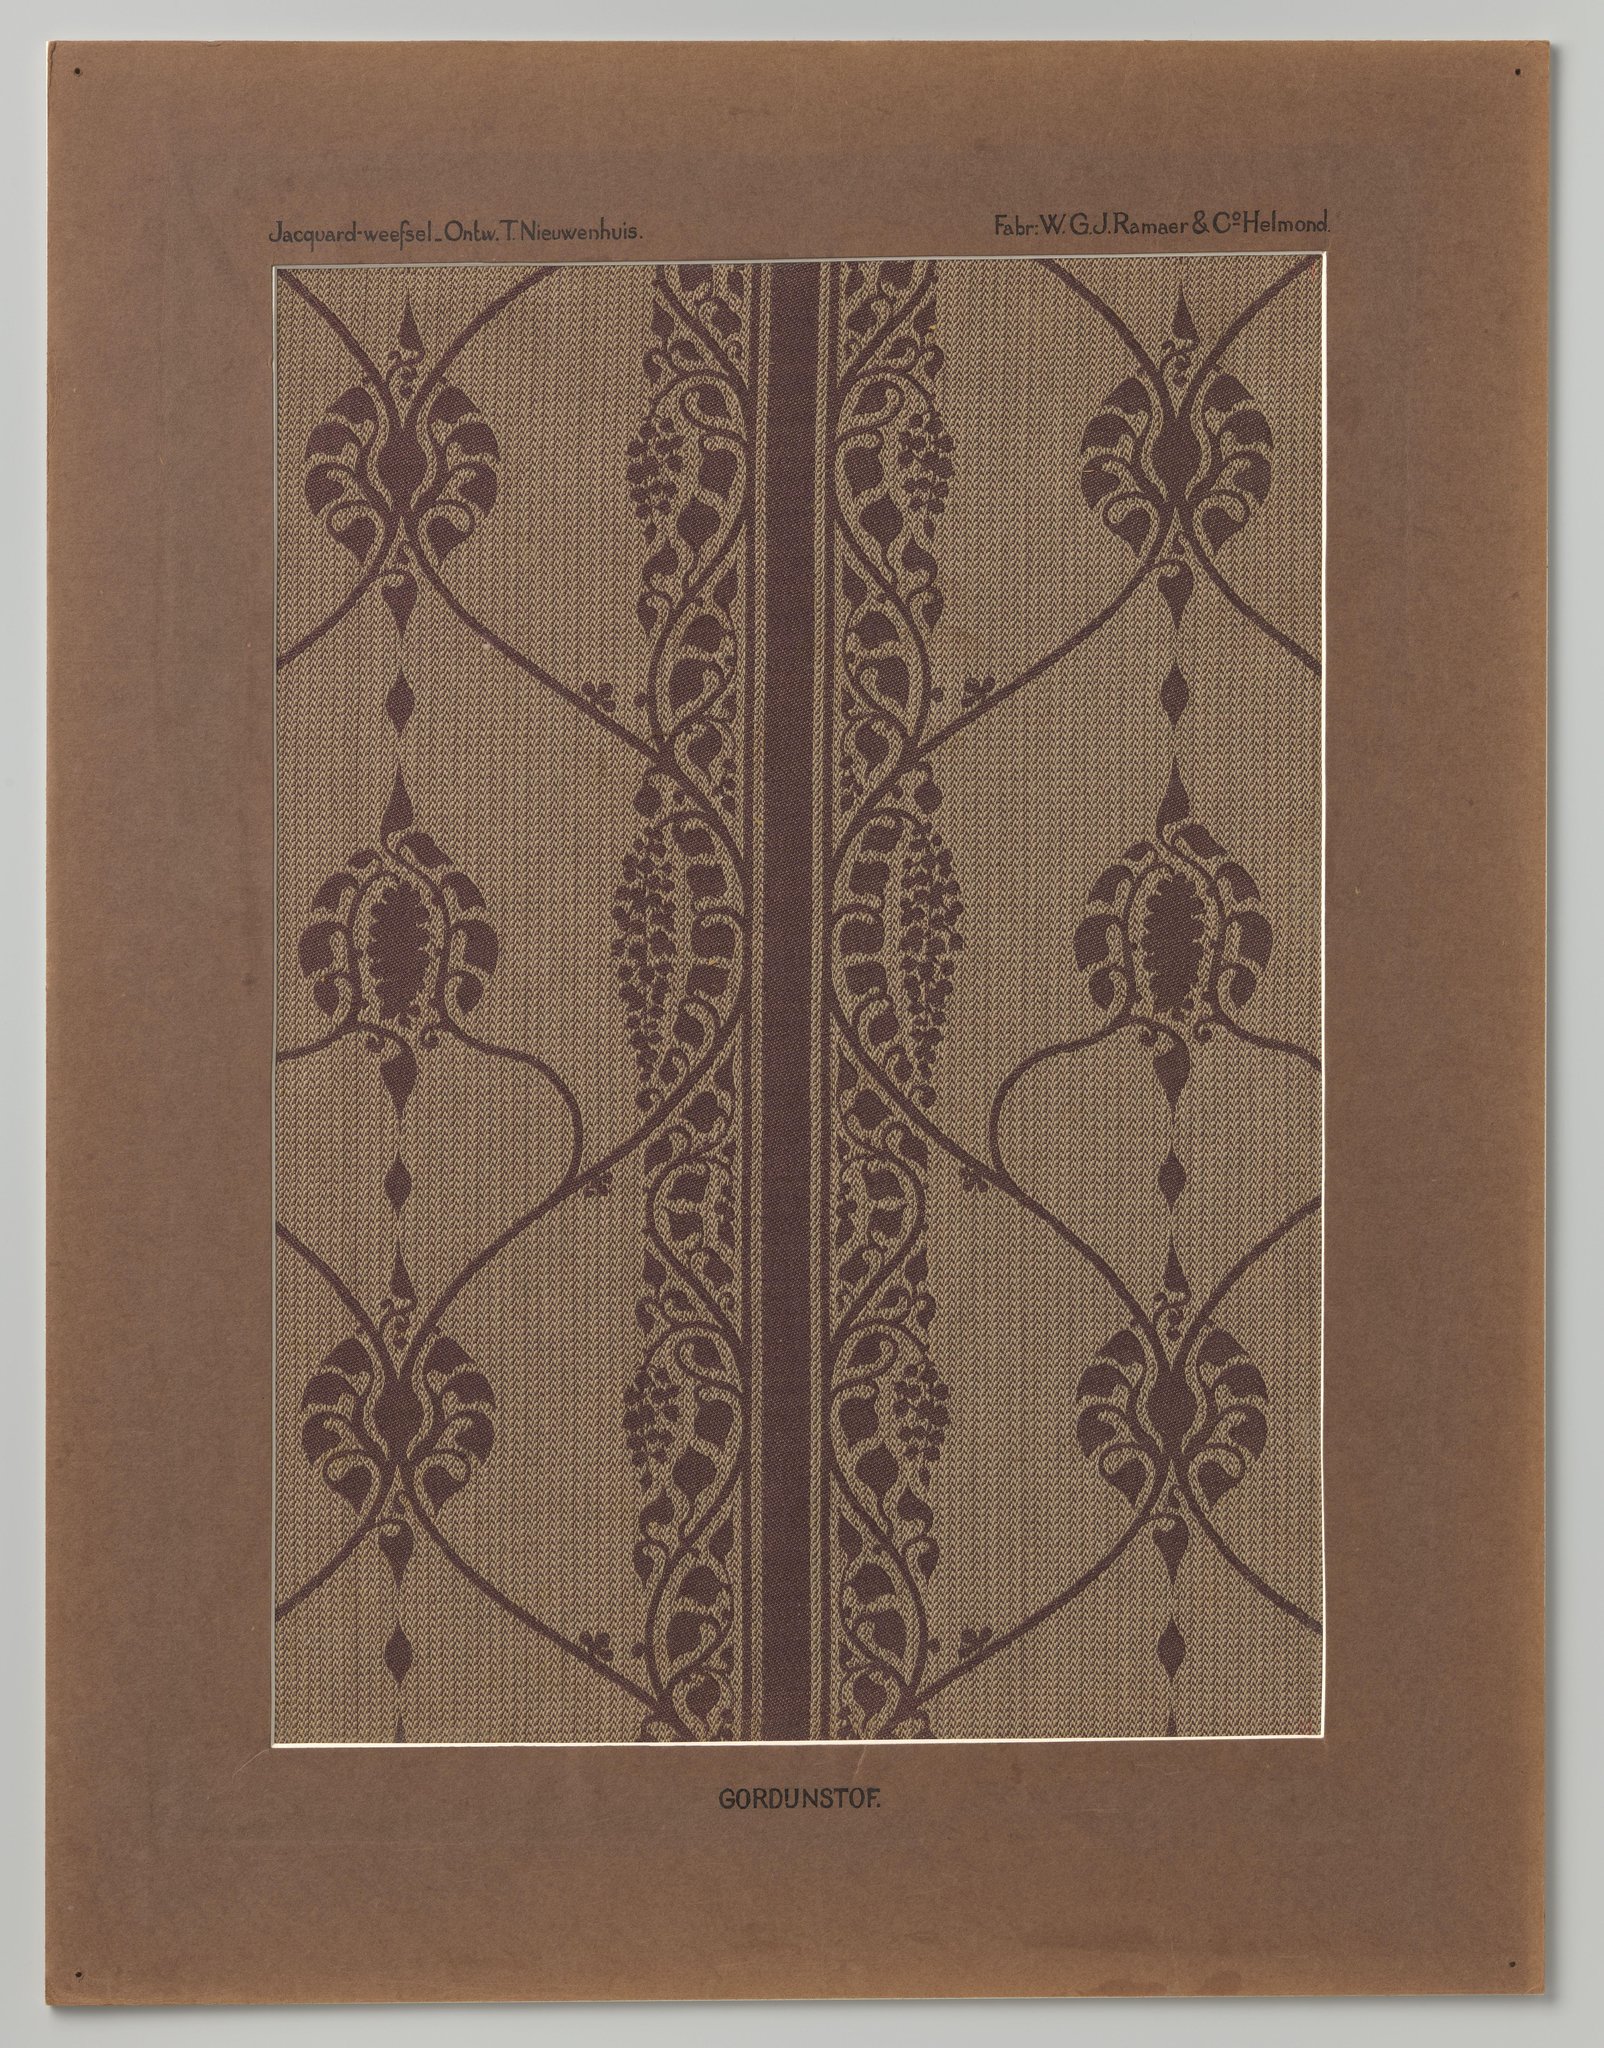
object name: sample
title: Staal gordijnstof naar ontwerp van Theo Nieuwenhuis in passe-partout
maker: theo nieuwenhuis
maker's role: designer, draughtsman, print maker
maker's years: 1866-1951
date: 1910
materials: cardboard, cotton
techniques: jacquard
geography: helmond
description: Staal gordijnstof naar ontwerp van Theo Nieuwenhuis in origineel passe-partout. Het patroon bestaat uit banen met spitsovalen, waarin gestileerde bladeren en druiventrossen, die wisselen af met verticale banen met aan weerszijden wijnranken en druiventrossen. Paarse inslag op naturel ketting.